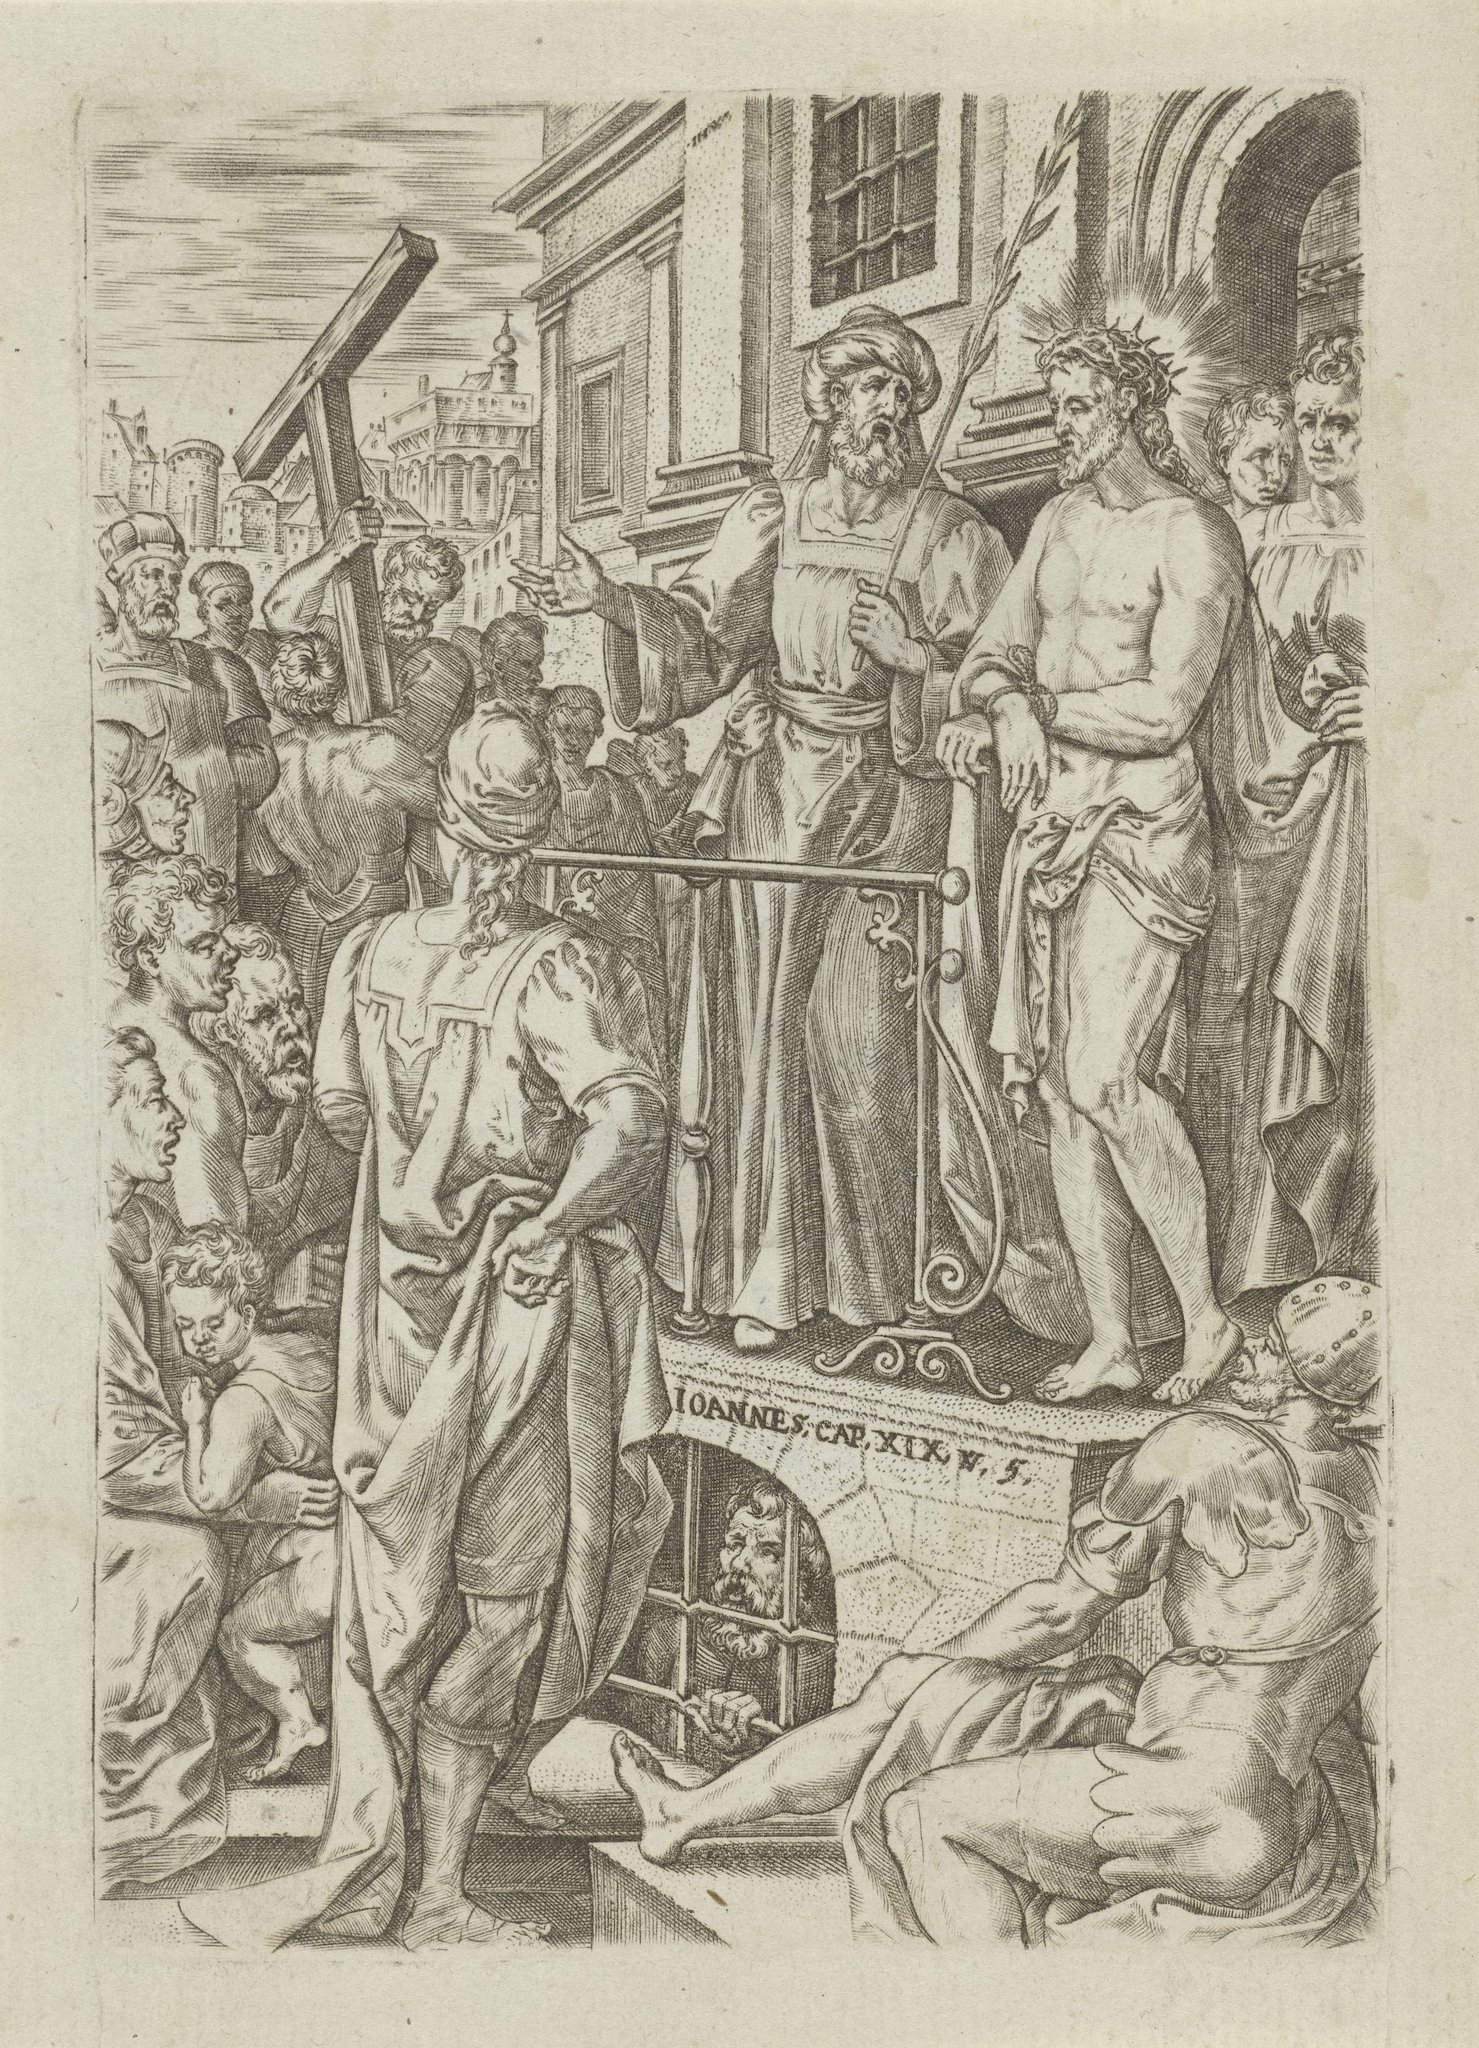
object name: print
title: Scènes uit de Bijbel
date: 1583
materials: paper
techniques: engraving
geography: antwerp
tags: pilate showing christ to the people, 'ostentatio christi', 'ecce homo' (john 19:4-6)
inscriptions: collector's mark: Lugt 2228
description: Boekillustratie bij het verhaal van de passie van Christus (Johannes 19:5). Pontius Pilatus toont Christus, met doornenkroon en spotmantel, aan het Joodse volk. De prent bevat een onderschrift met een verwijzing naar de bijhorende Bijbelpassage.